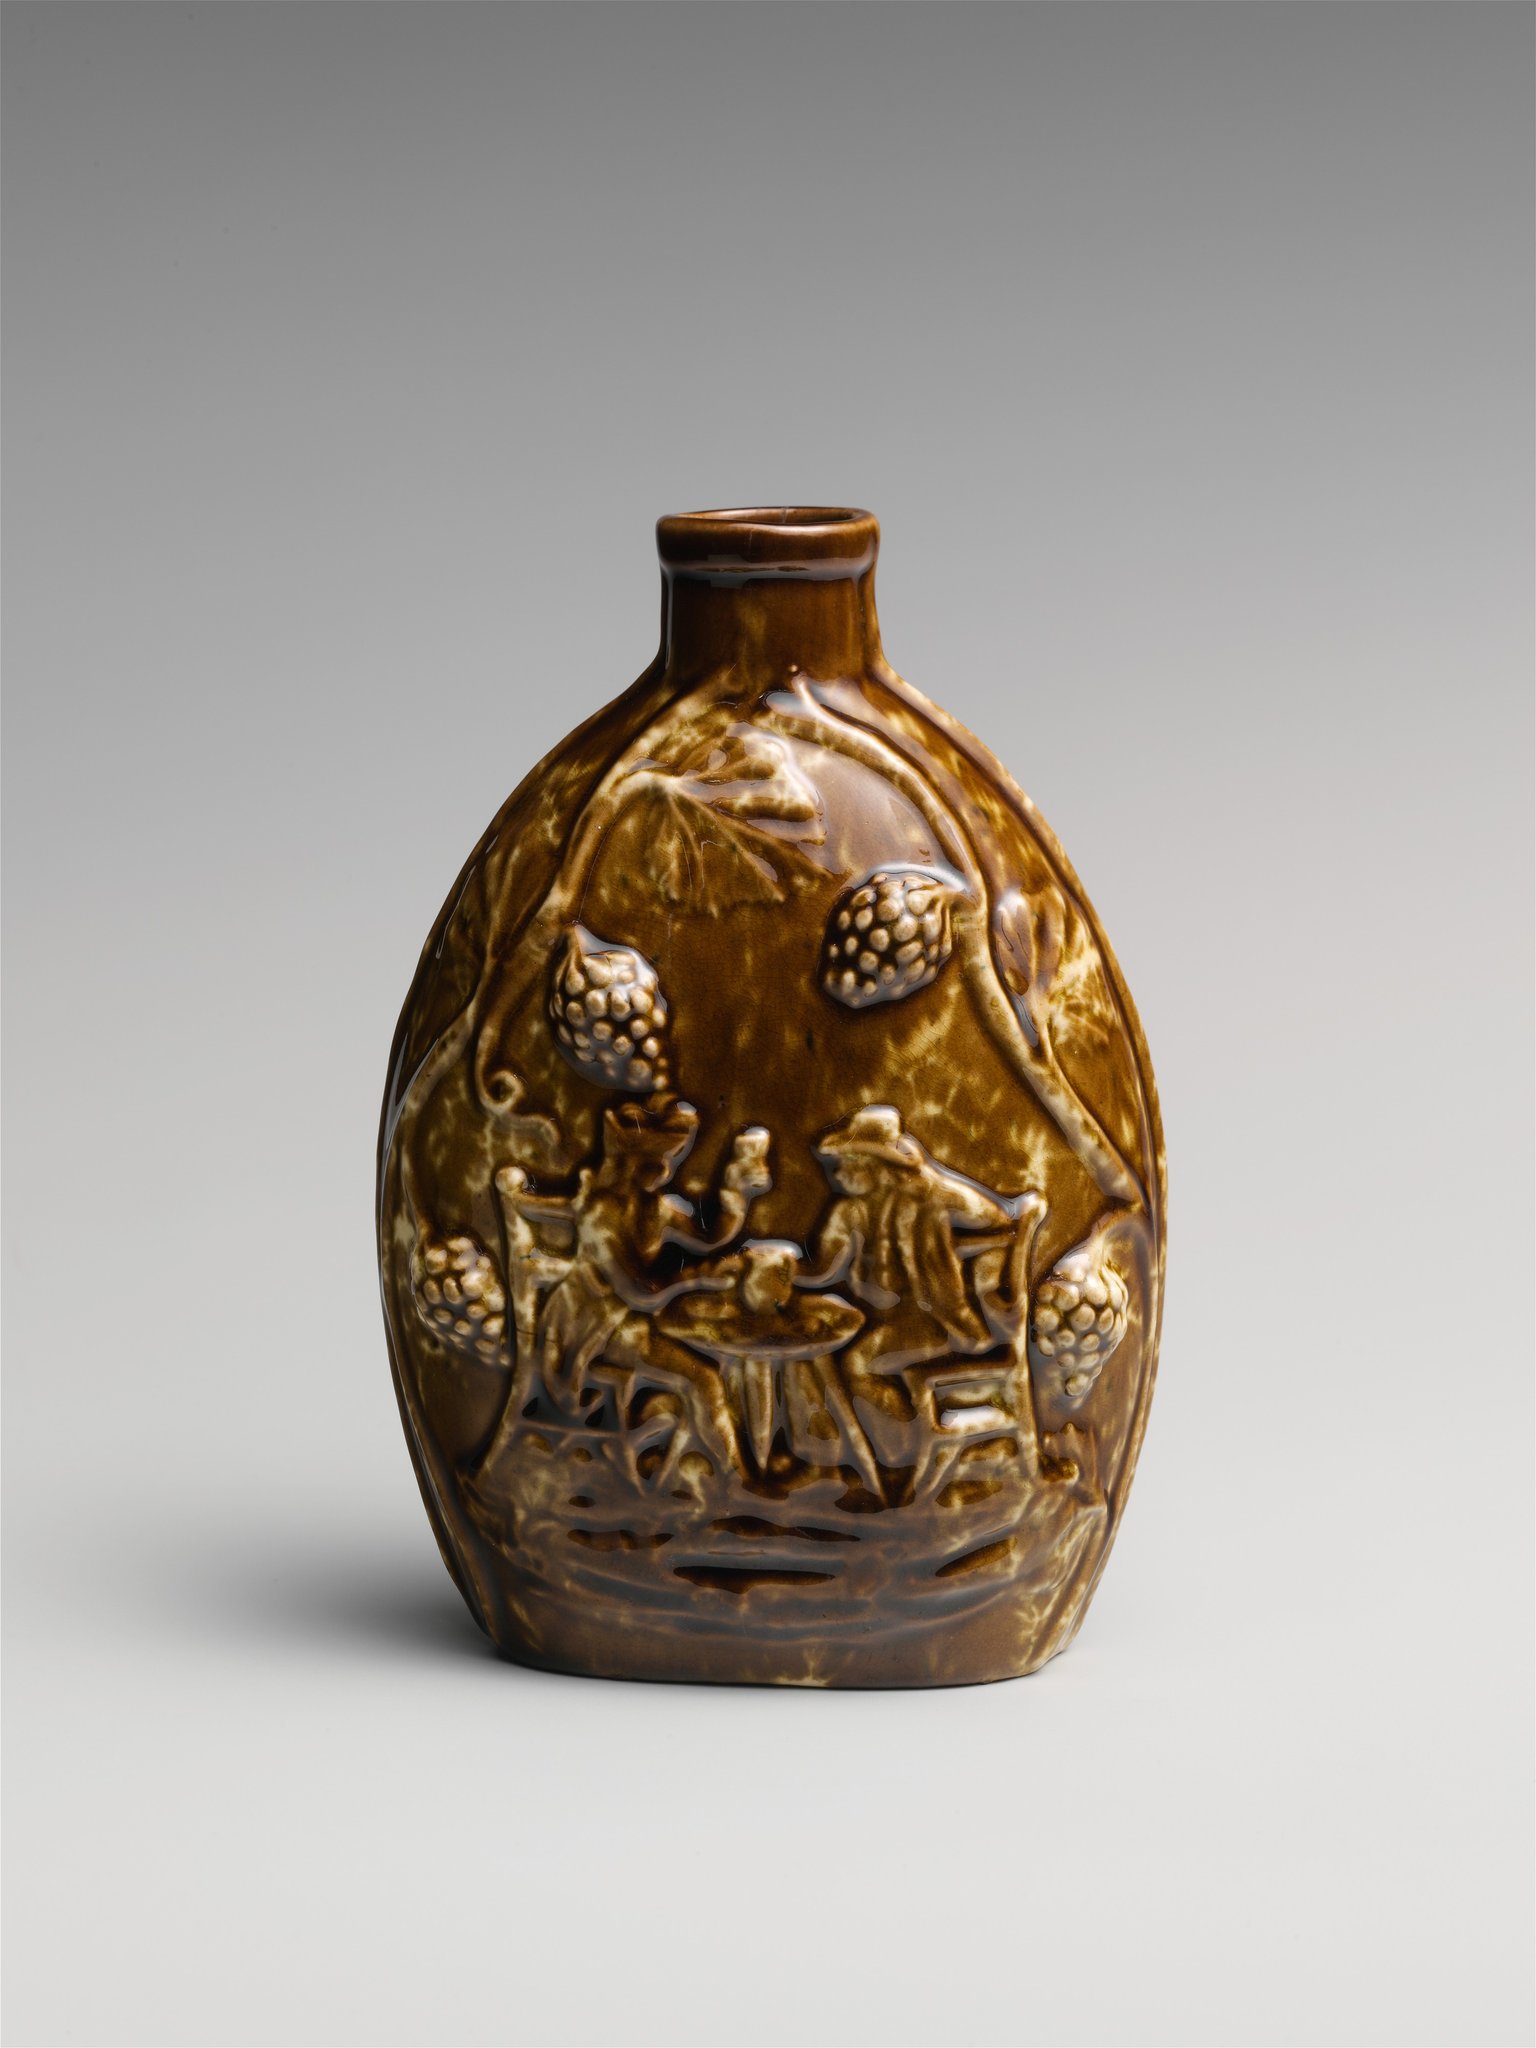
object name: flask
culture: american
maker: united states pottery company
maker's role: manufacturer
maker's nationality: american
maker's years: 1852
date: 1852-1858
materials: earthenware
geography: united states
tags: men,drinking